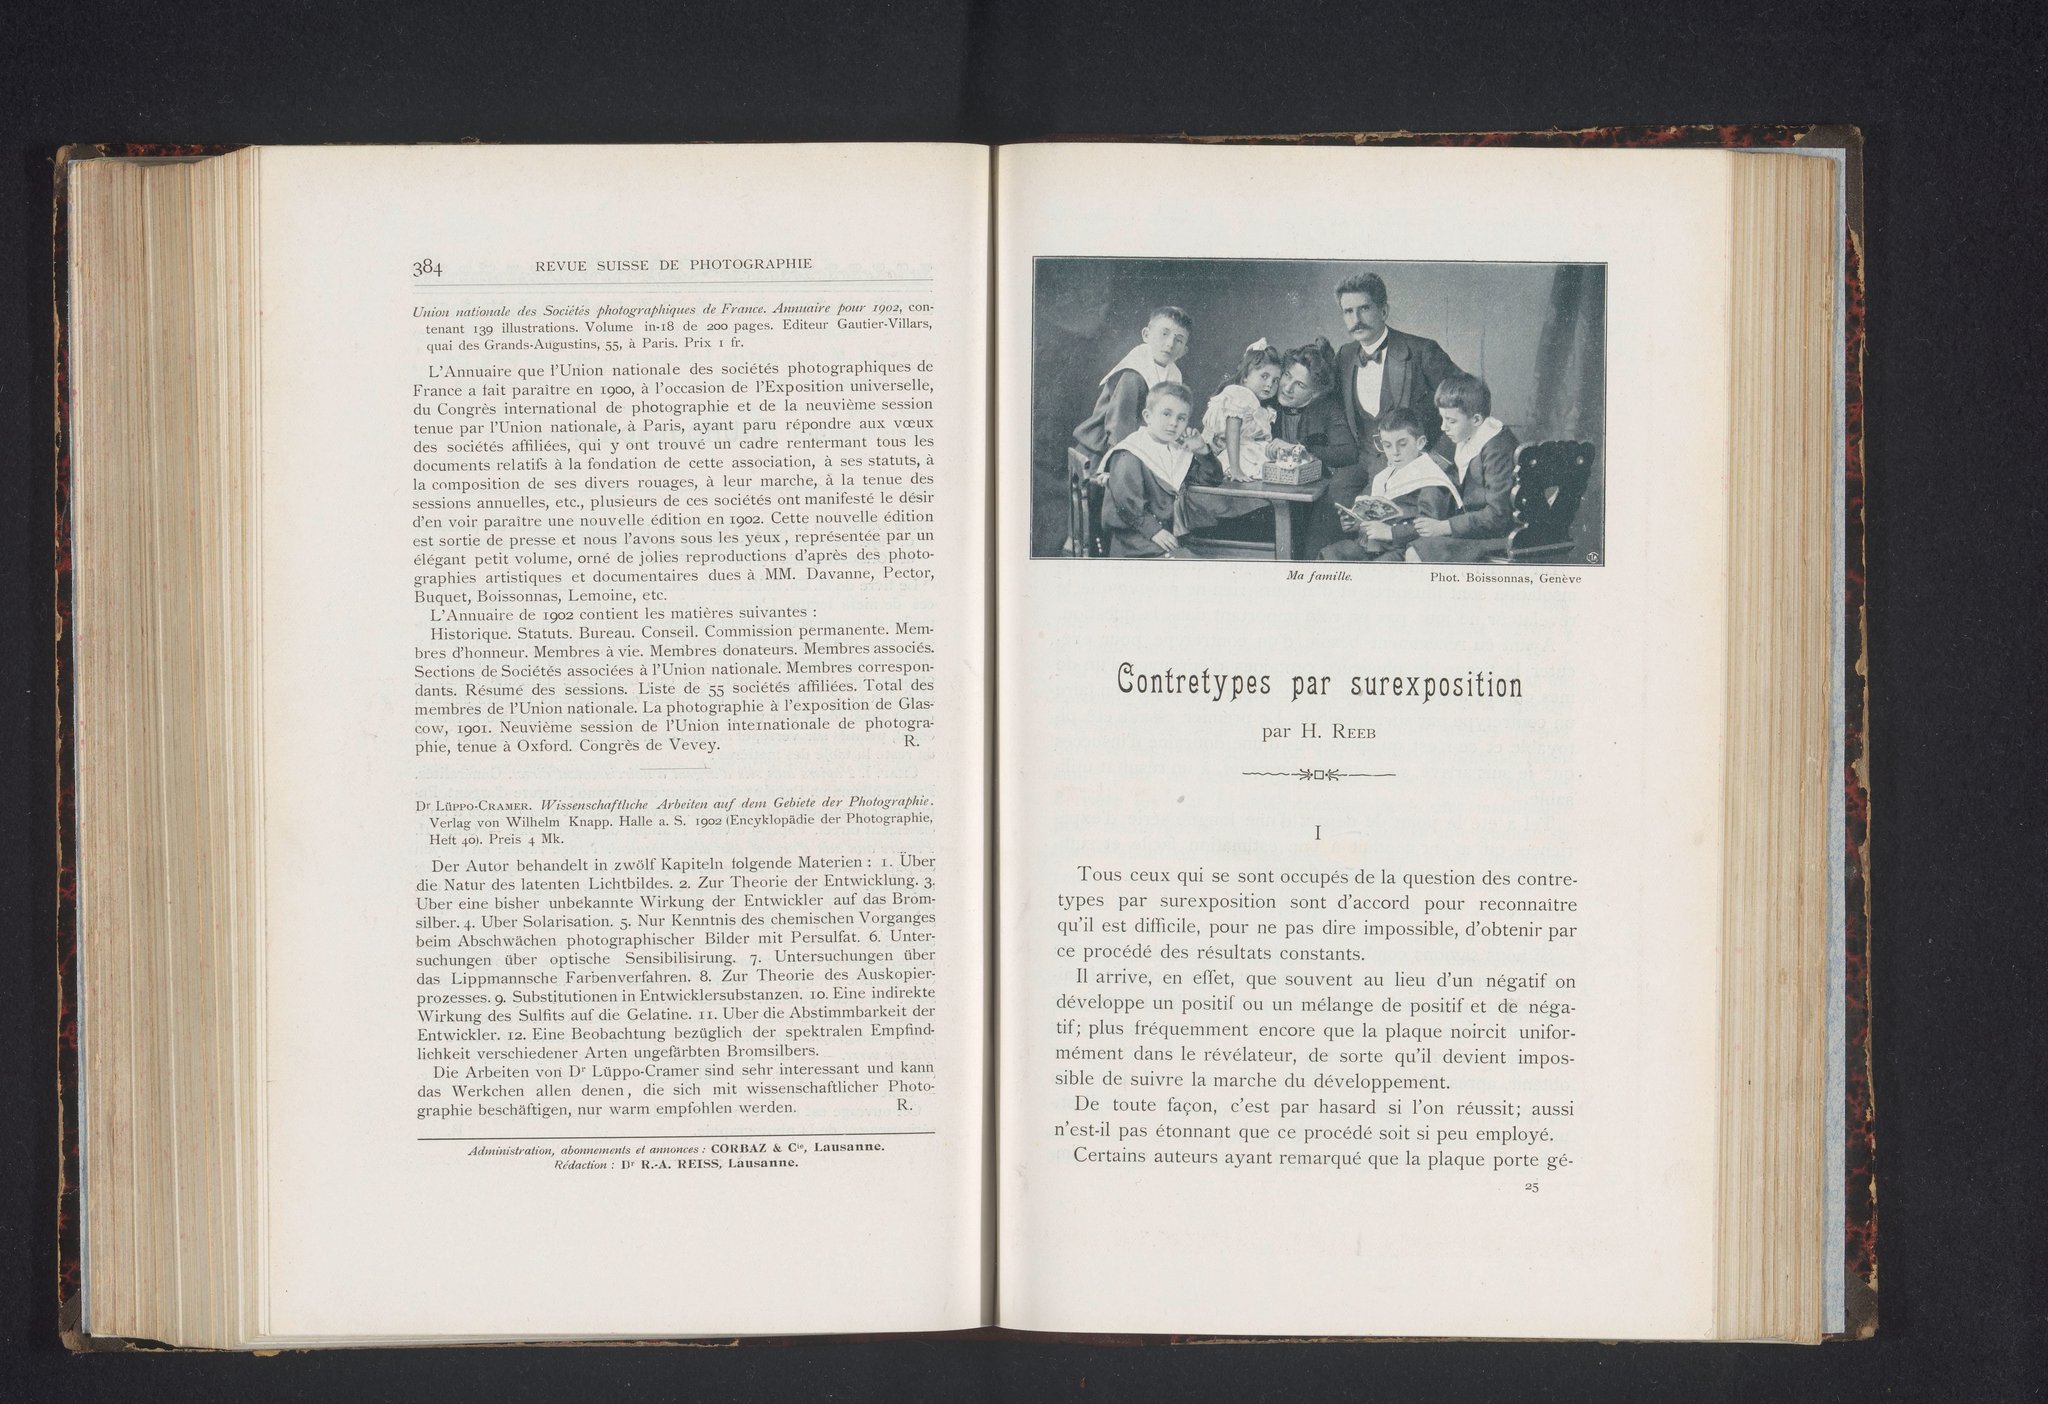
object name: photomechanical print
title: Gezinsportret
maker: frédéric boissonnas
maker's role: fotograaf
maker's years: 1858-1946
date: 1897-1902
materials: paper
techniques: autotype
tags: family, relationship, descent, anonymous historical persons portrayed in a group, in a group-portrait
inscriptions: monogram: ‘C. Cie’